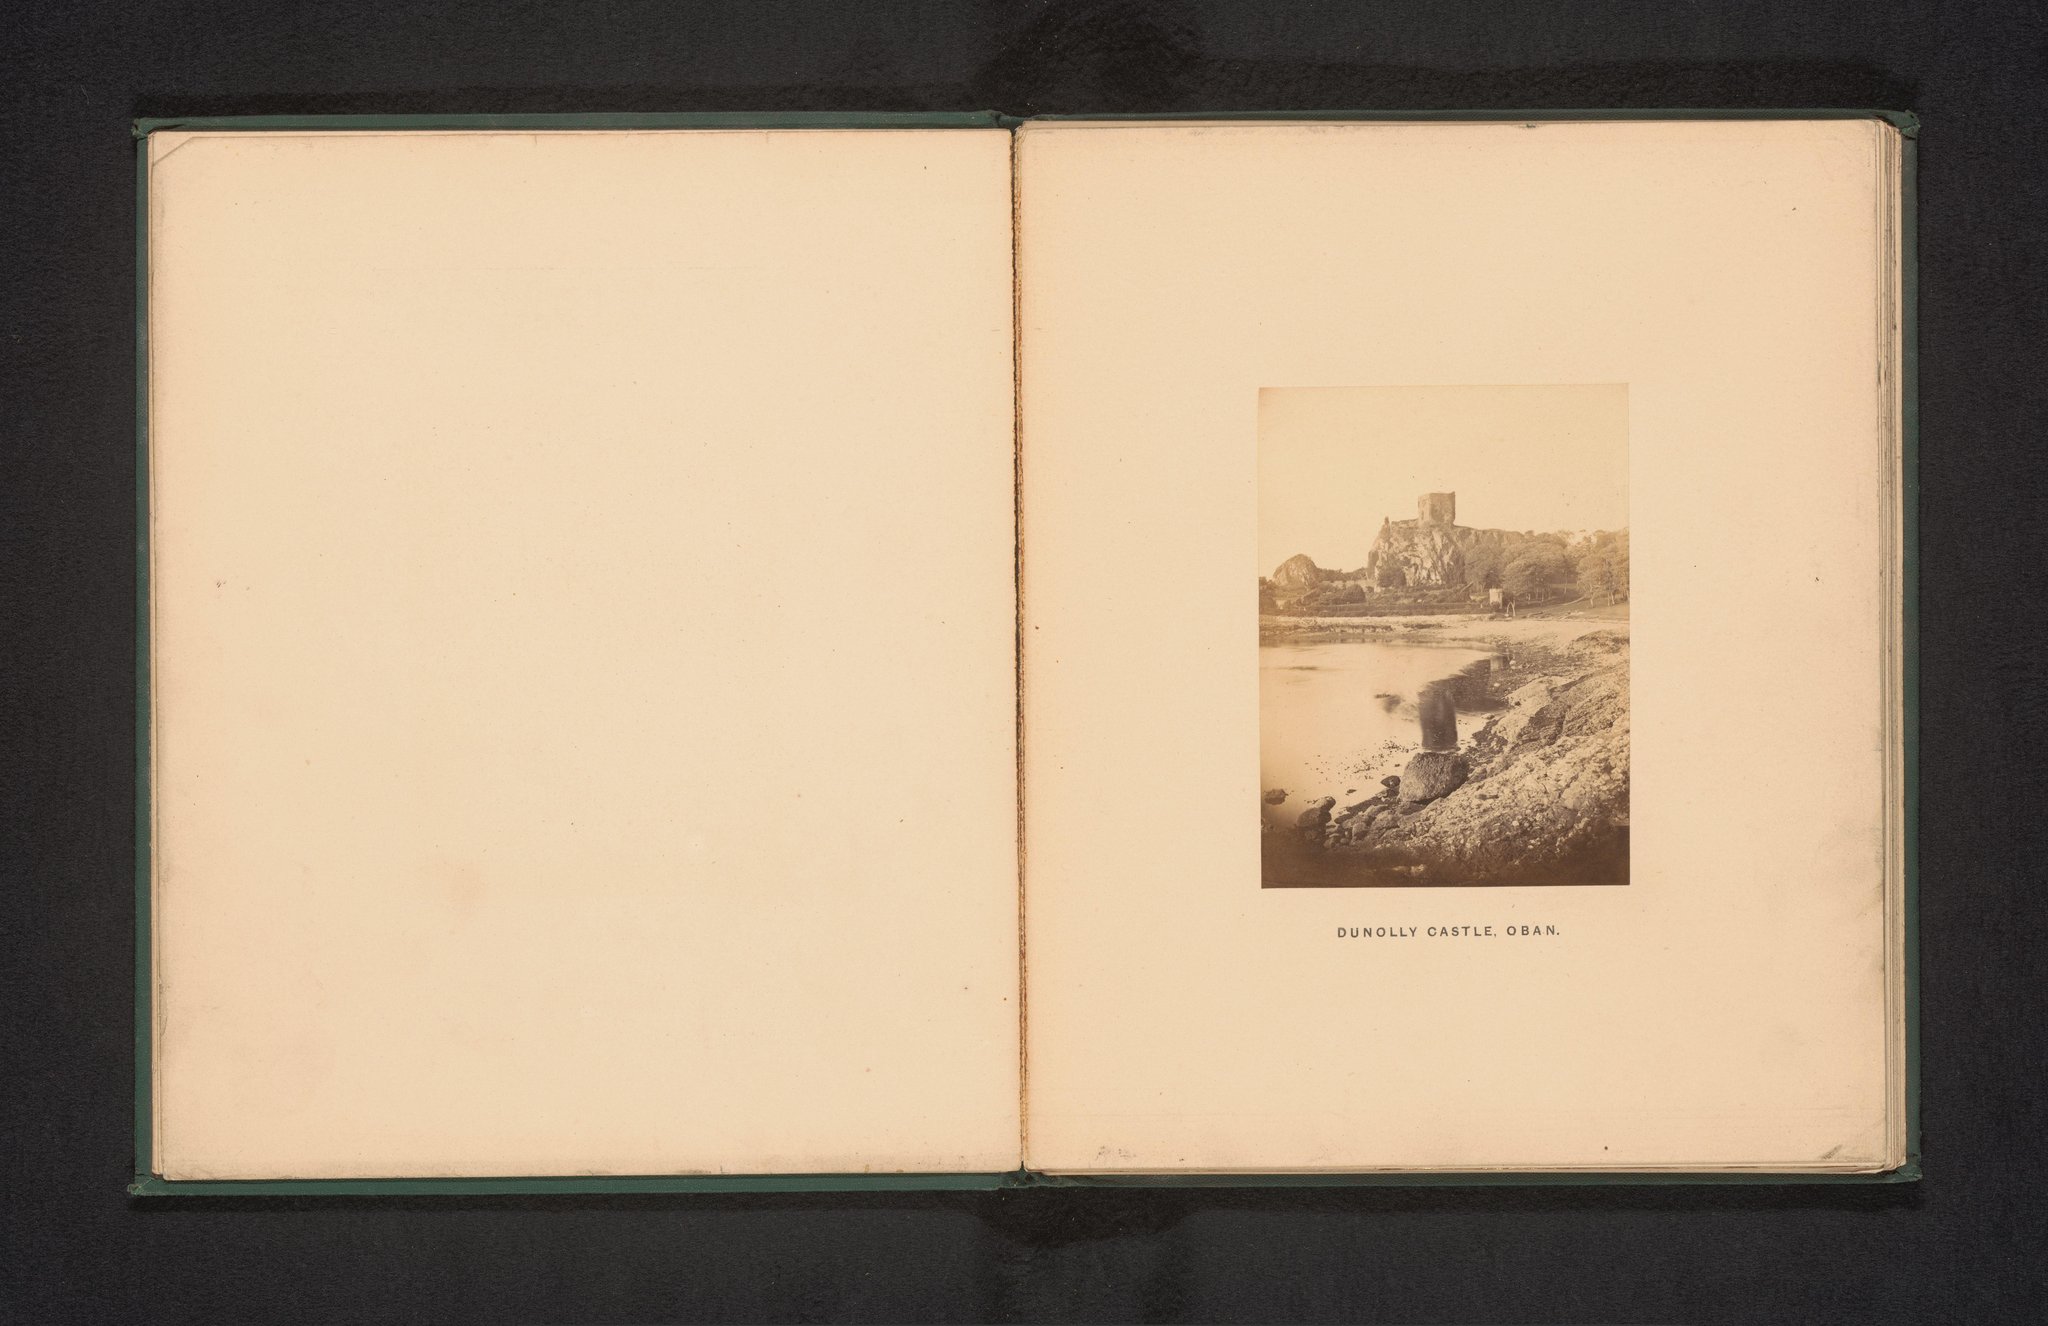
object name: photograph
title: Dunolly Castle, Oban.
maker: Anonymous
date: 1862-1867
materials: photographic support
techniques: albumen print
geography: oban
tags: castle, landscapes with waters, waterscapes, seascapes (in the temperate zone), landscape with tower or castle